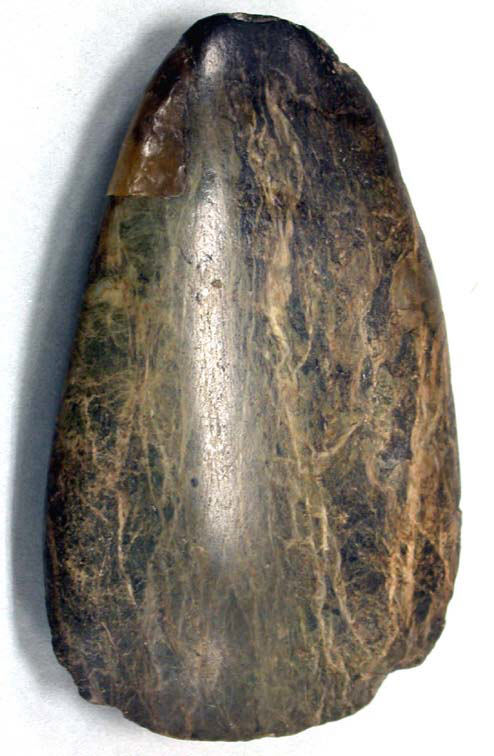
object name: axe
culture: new caledonian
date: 1902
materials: jade